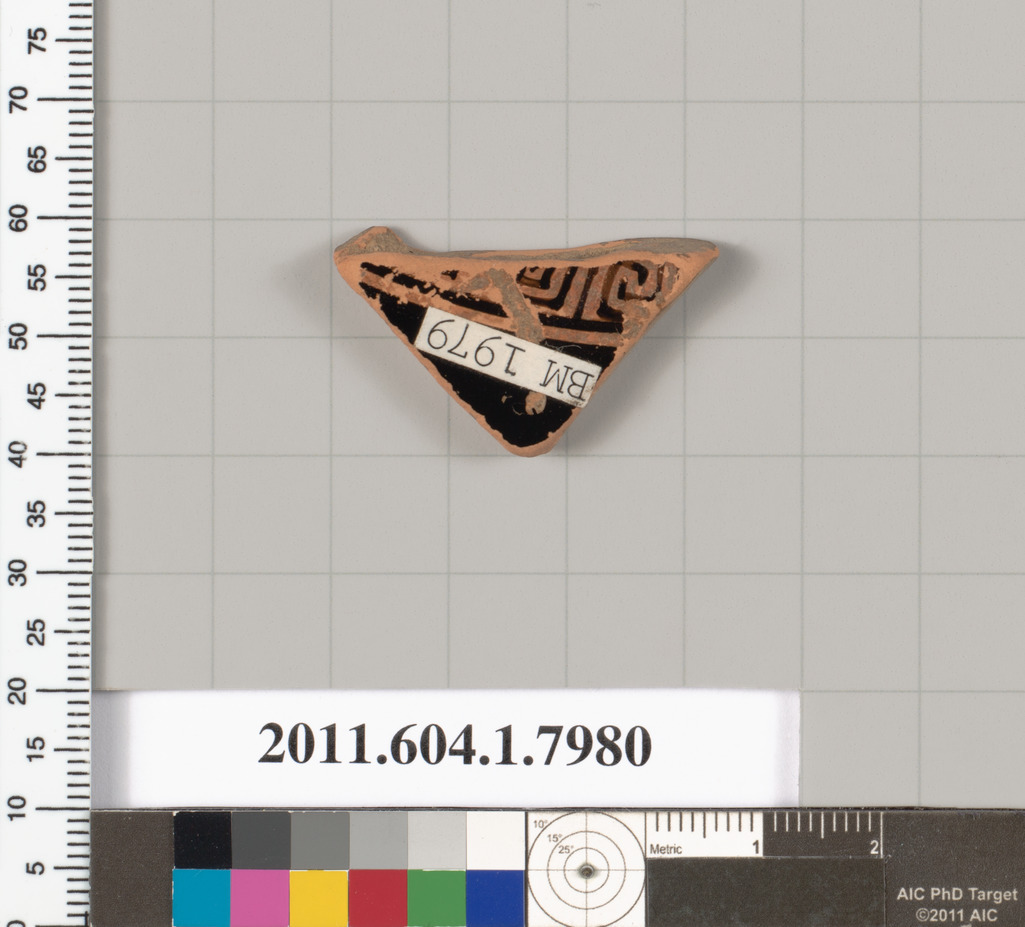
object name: kylix fragment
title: Terracotta fragment of a kylix (drinking cup)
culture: greek, attic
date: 460-450 BCE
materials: terracotta